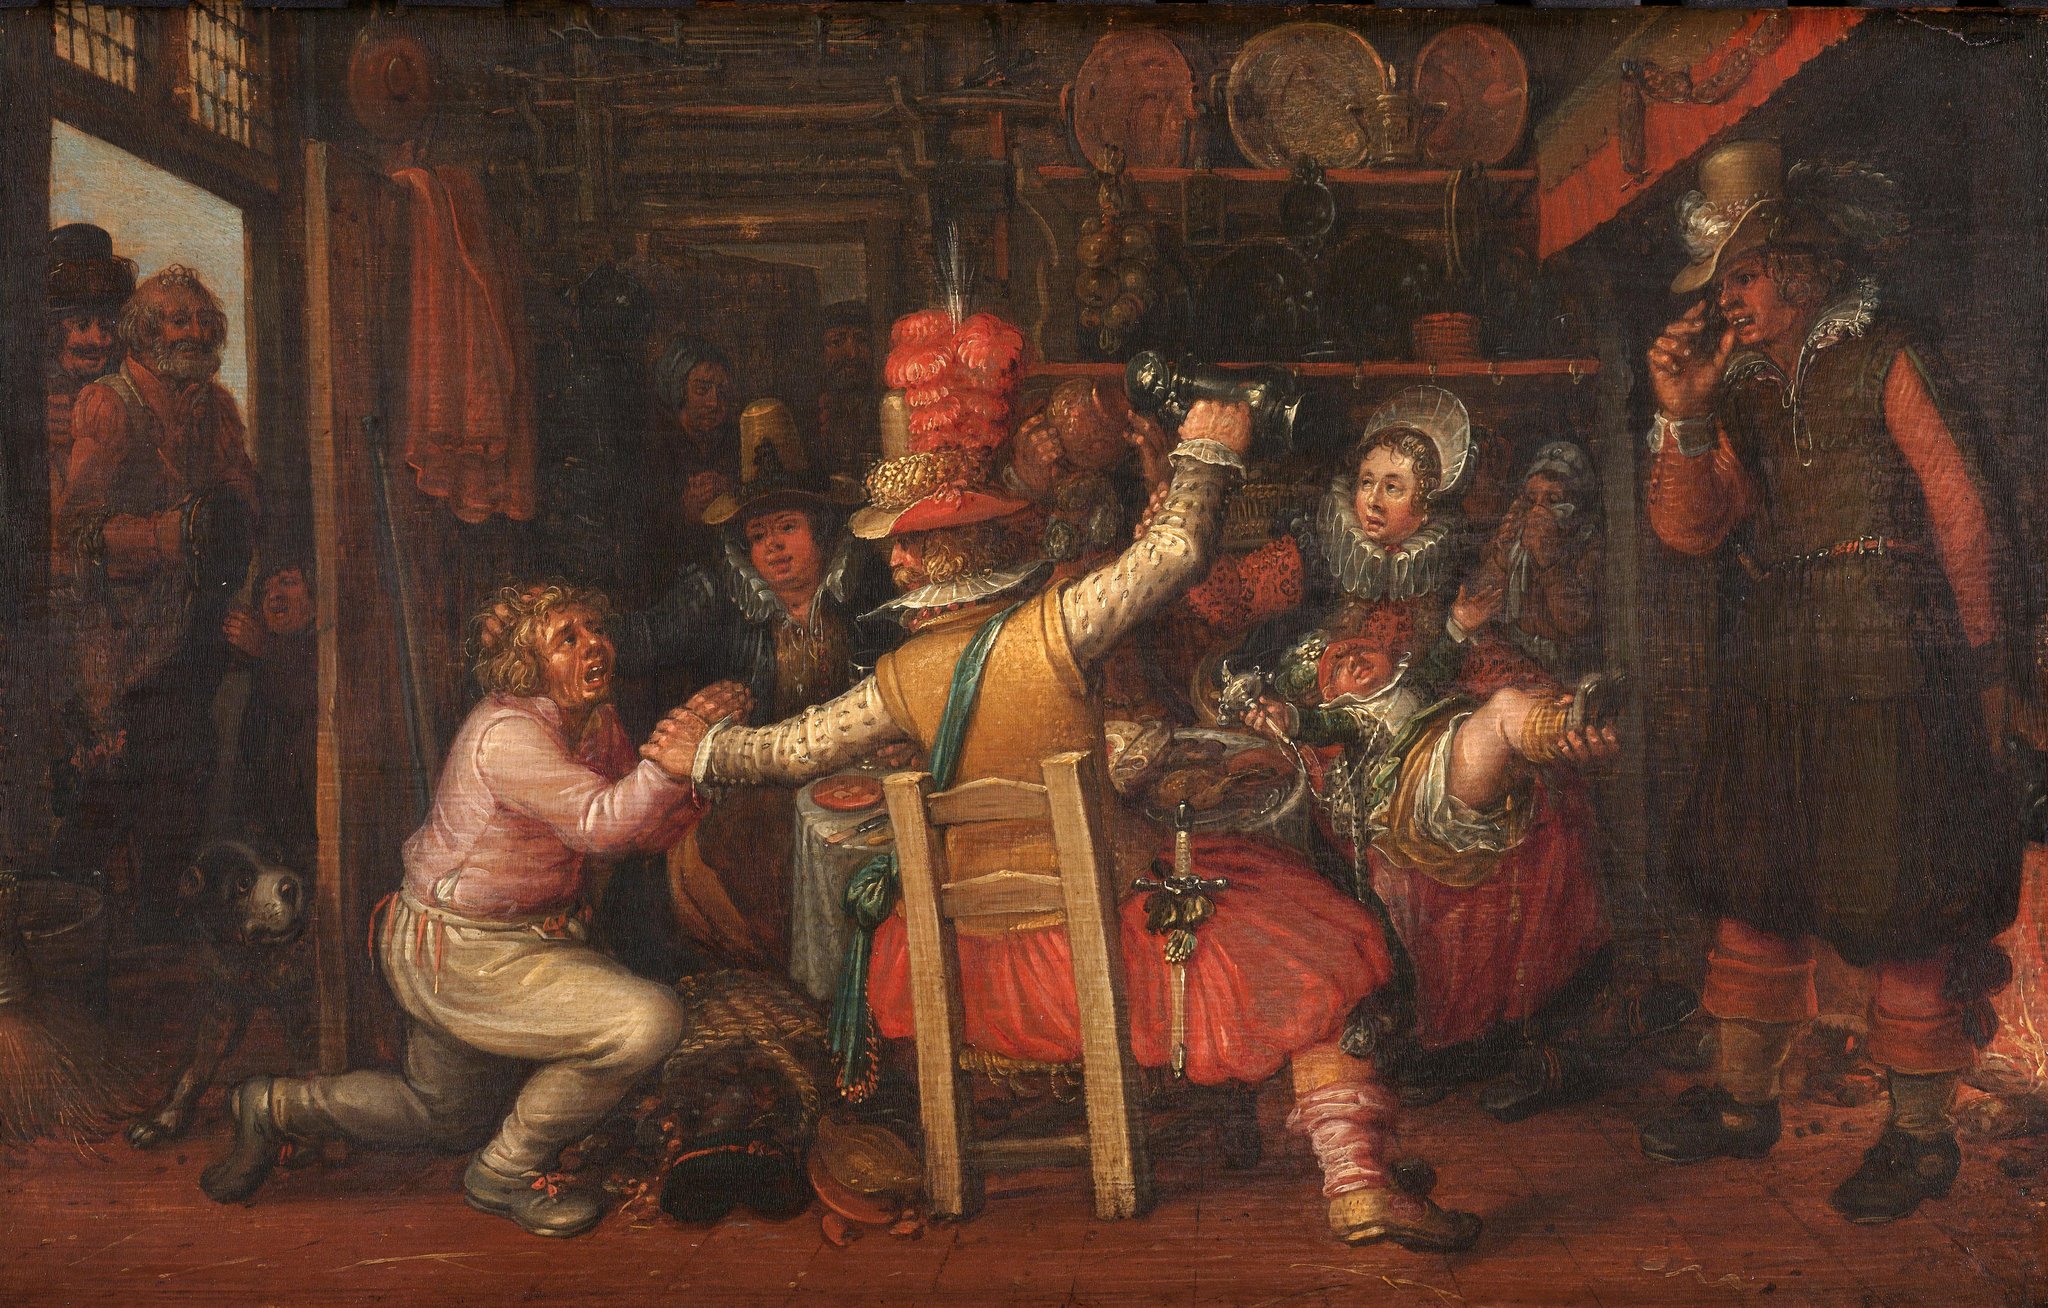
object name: painting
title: The Peasant's Misfortune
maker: david vinckboons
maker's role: draughtsman, painter, print maker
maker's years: 1576-1629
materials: oil, panel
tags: fight between farmers and soldiers, plundering ~ soldiers, soldiers and civilians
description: Boerenverdriet. Een groep rijk geklede stedelingen doet zich in een boerenwoning tegoed aan het eten en drinken van de boeren. Links wordt een boer die een mand met groente en fruit heeft gebracht met geweld op de knieën gedwongen. Een elegante vrouw zittend aan de tafel heeft een plassend kind op schoot. Op de achtergrond en in de deuropening kijken boeren angstig toe. Pendant van SK-A-1352.